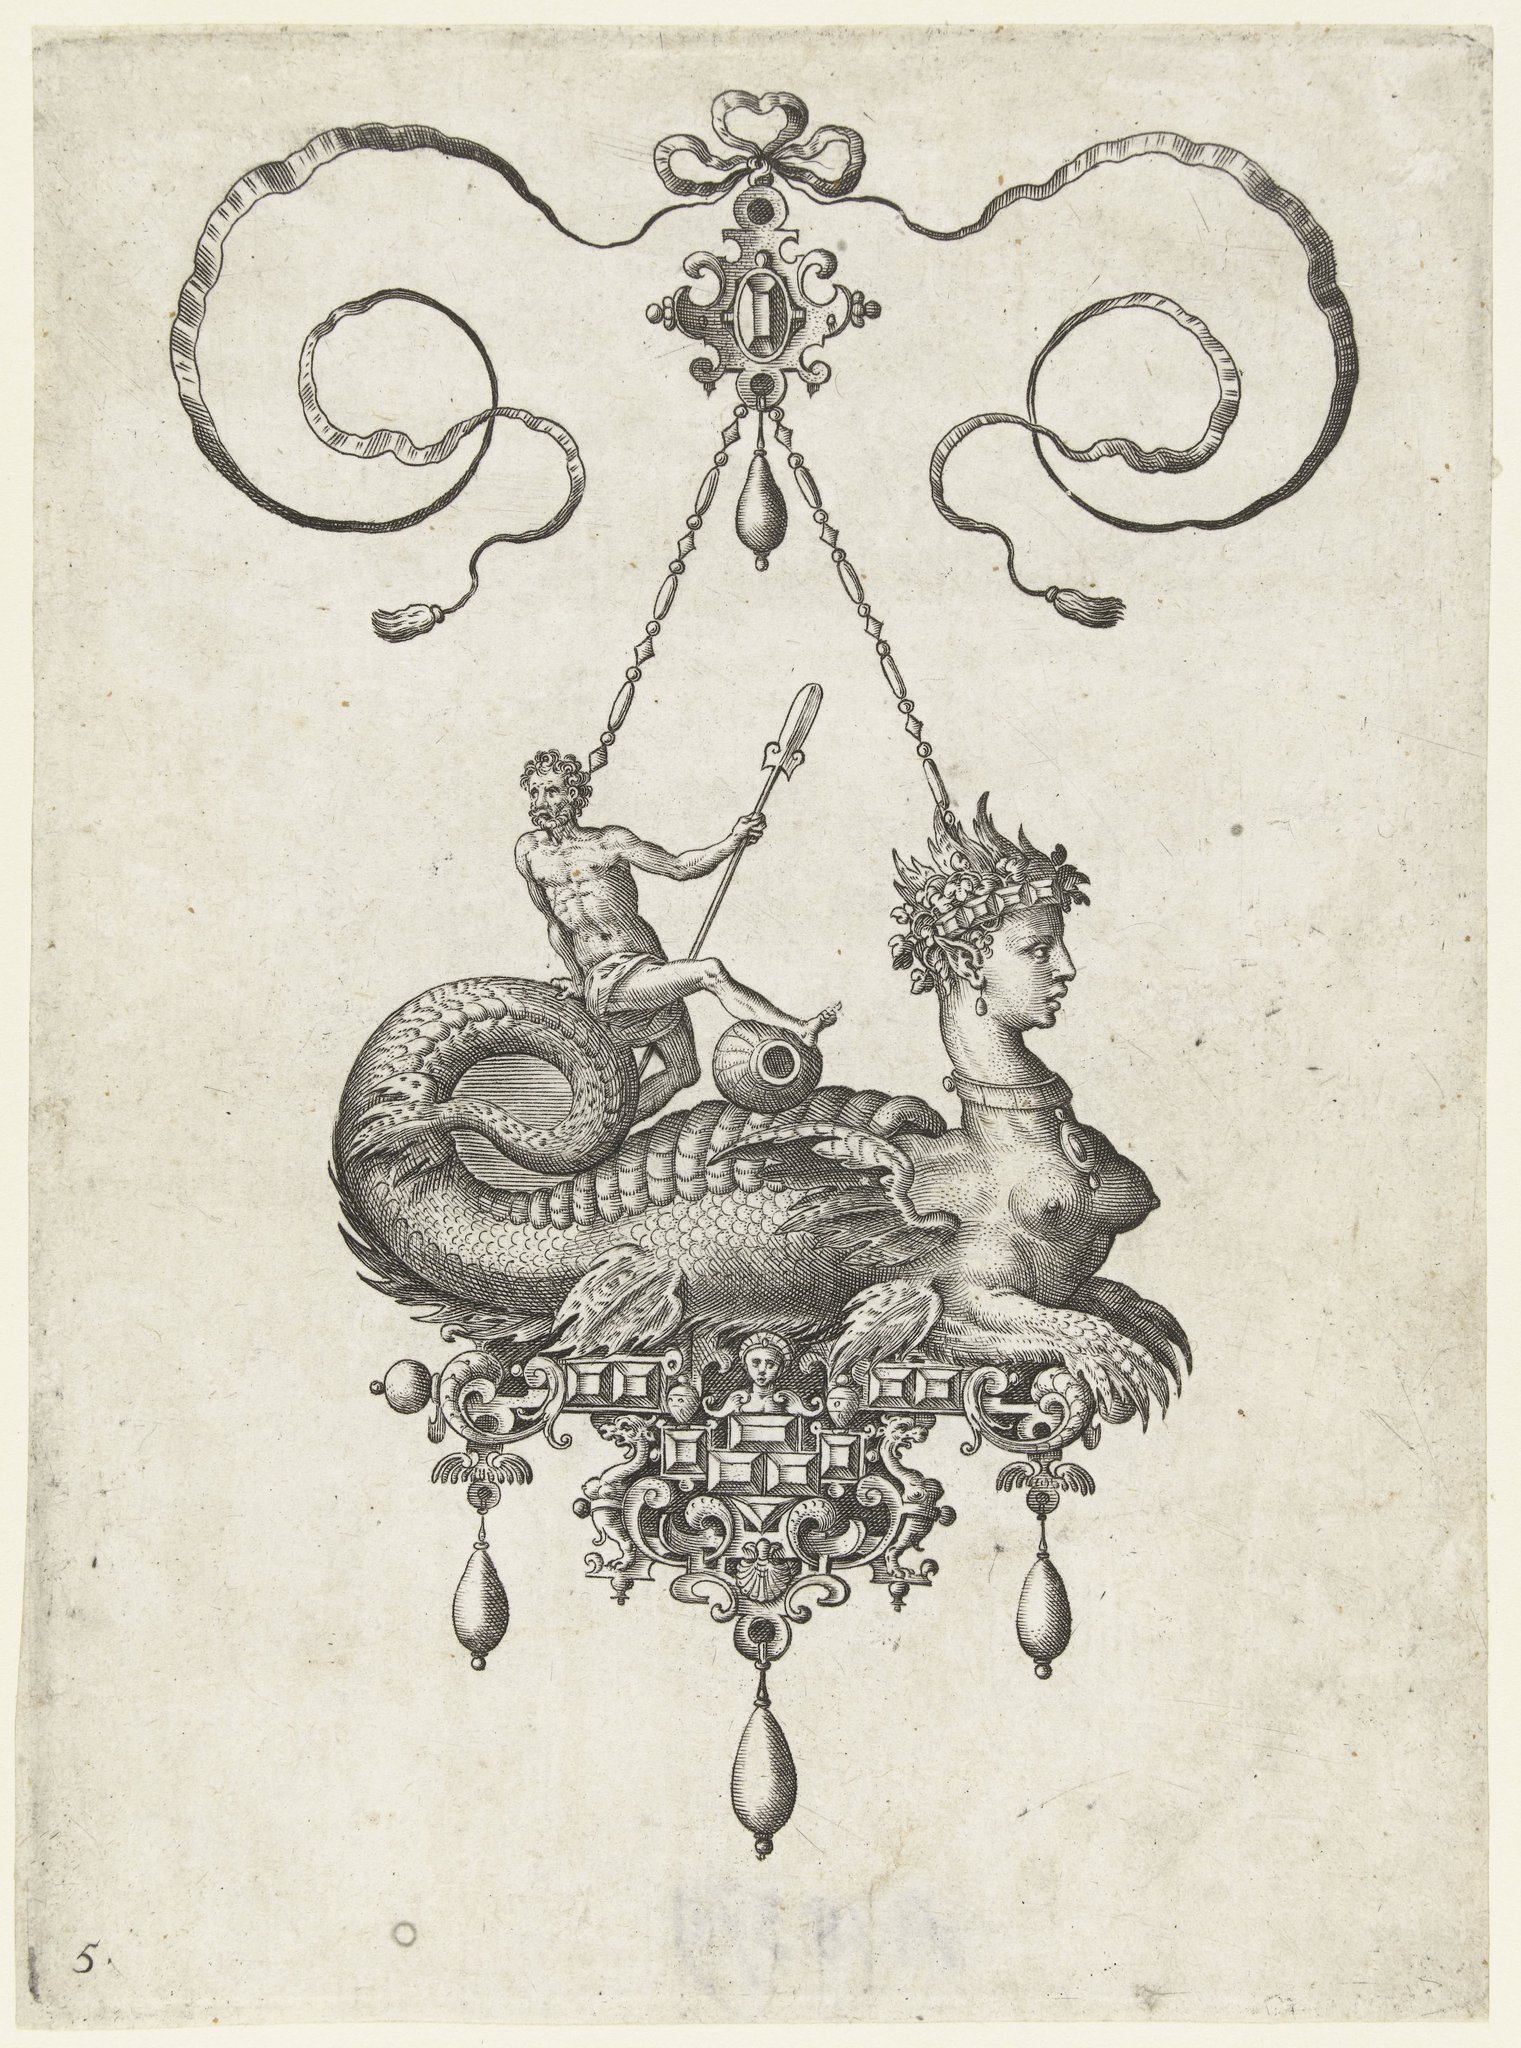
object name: ornament print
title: Hanger met sfinx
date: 1582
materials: paper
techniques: engraving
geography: netherlands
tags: sphinx (lion/woman); 'sfinge' (ripa), pendant, trinket, 'breloque'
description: Het onderlijf van de sfinx is vervangen door het achterstuk en de staart van een vis. Op de staart zit een man met een roeispaan. Een van 7 deels genummerde bladen afkomstig uit een serie van 10 bladen met hangers. Aan elke hanger hangen drie parels.